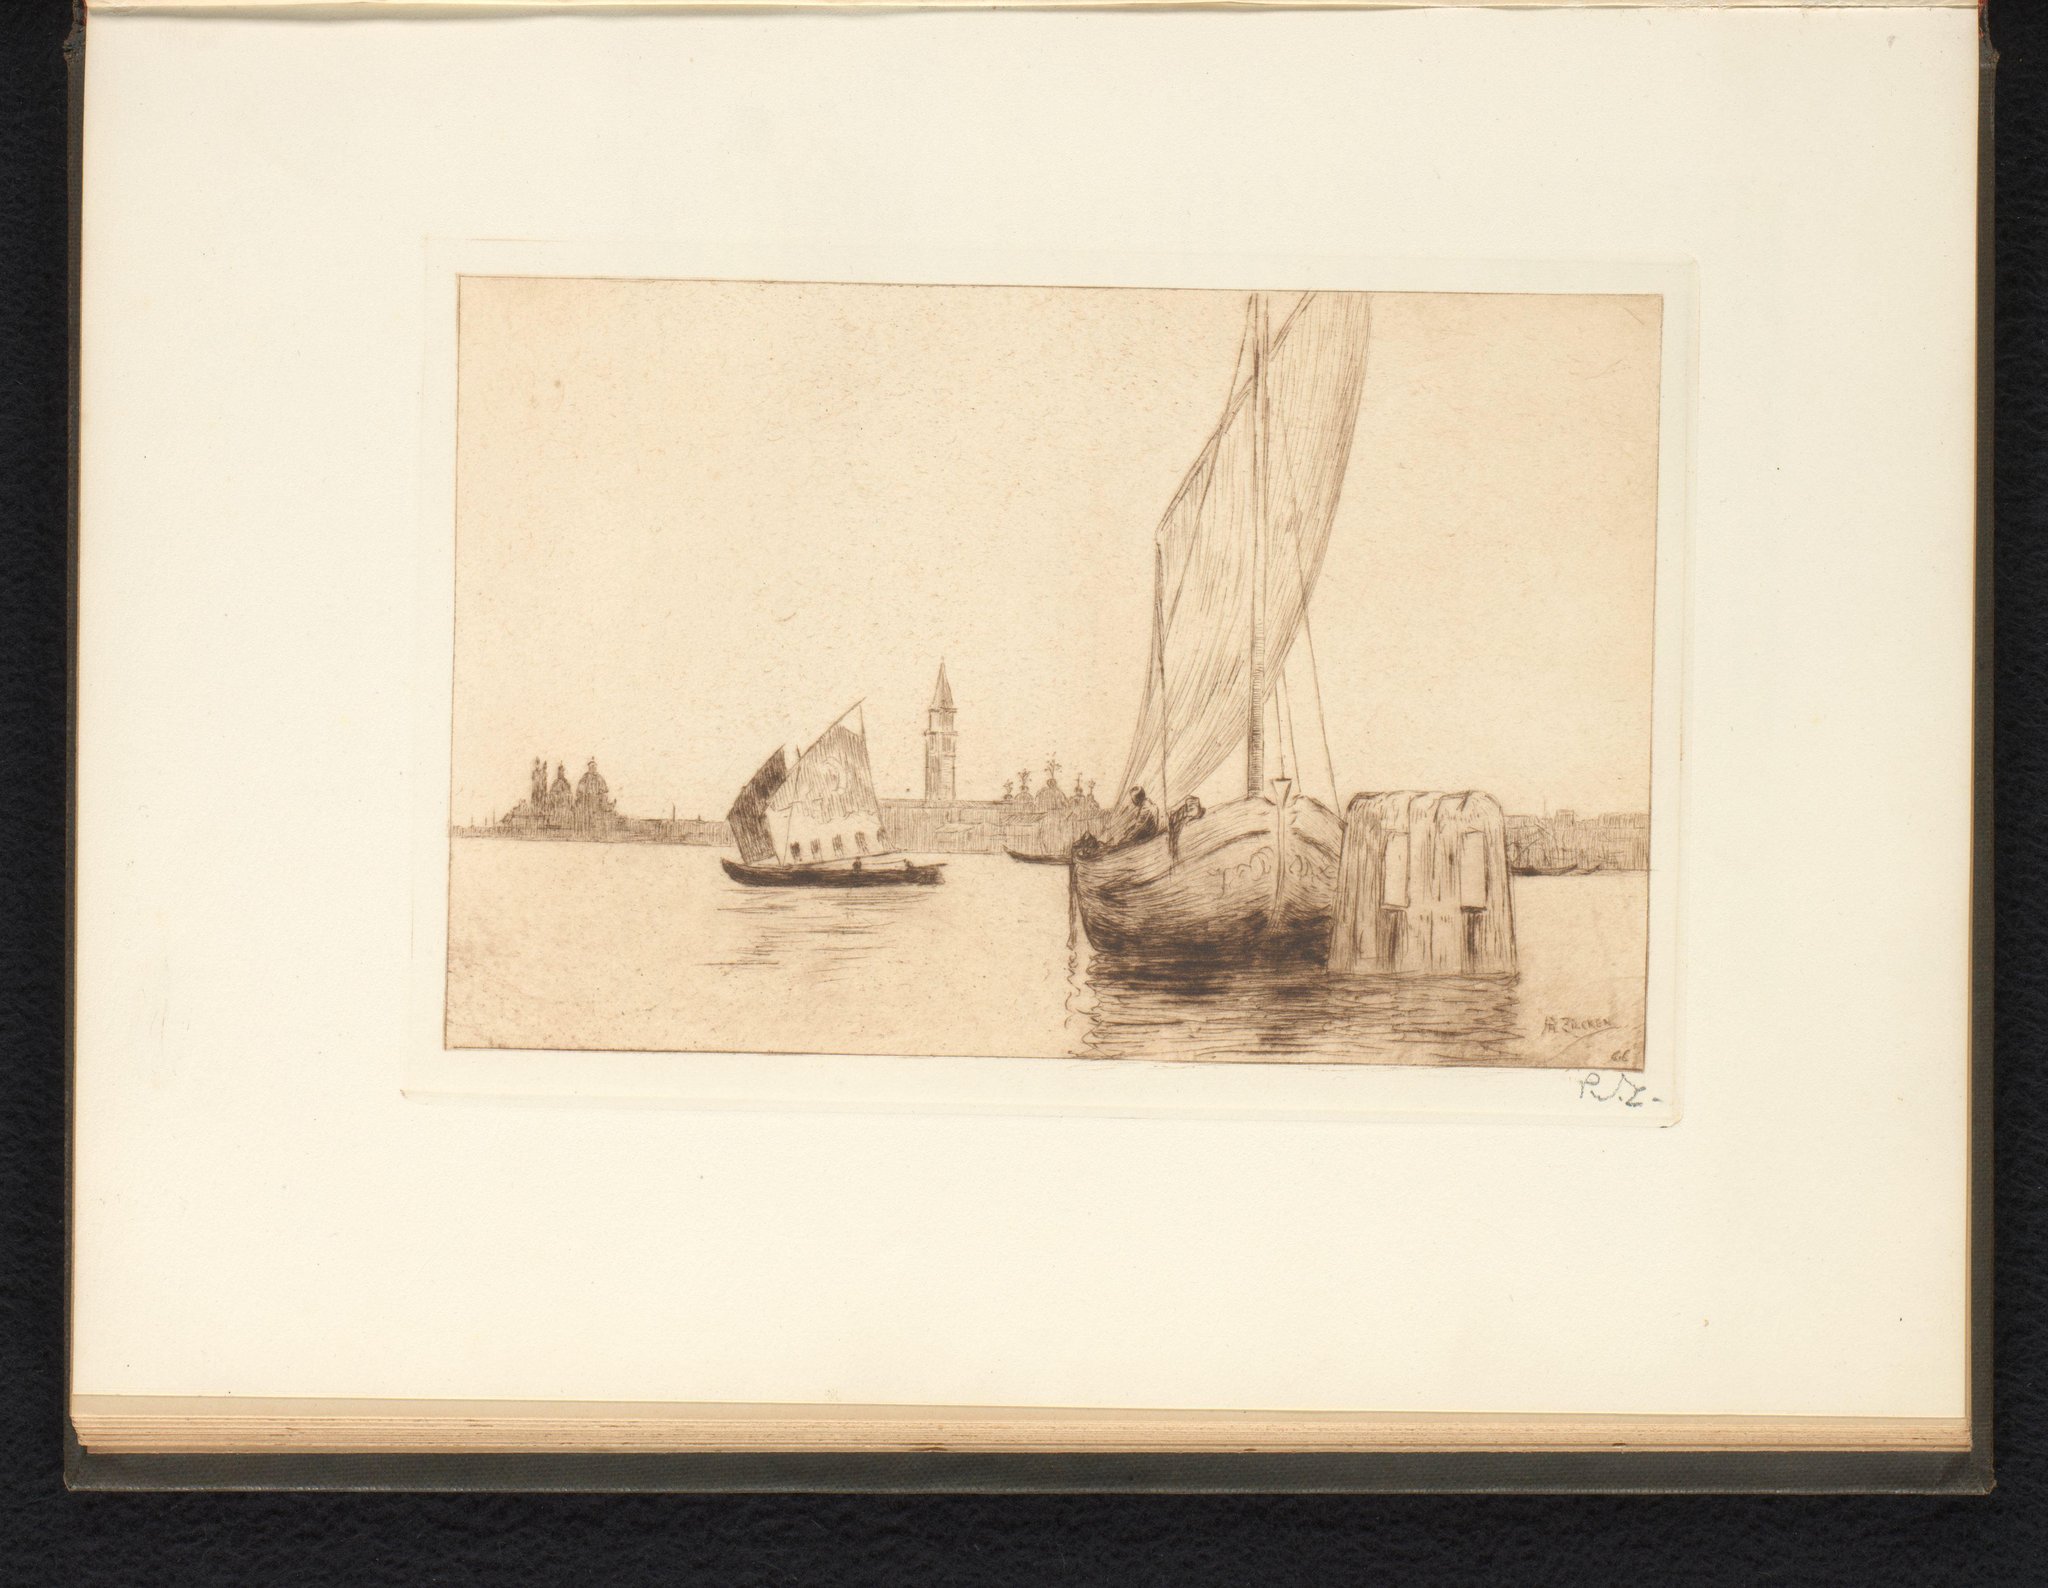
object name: print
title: In de lagune van Venetië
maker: philip zilcken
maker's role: draughtsman, painter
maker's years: 1857-1930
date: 1920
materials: paper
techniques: drypoint, etching, intaglio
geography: amsterdam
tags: gulf, bay, sailing-ship, sailing-boat, hôtel, i.e. small palace in city, venice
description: Prent uit: Zilcken, Philip. Reisindrukken: in Provence, Venetiaansch leven, in en om Caïro. Amsterdam: Elsevier, 1920.